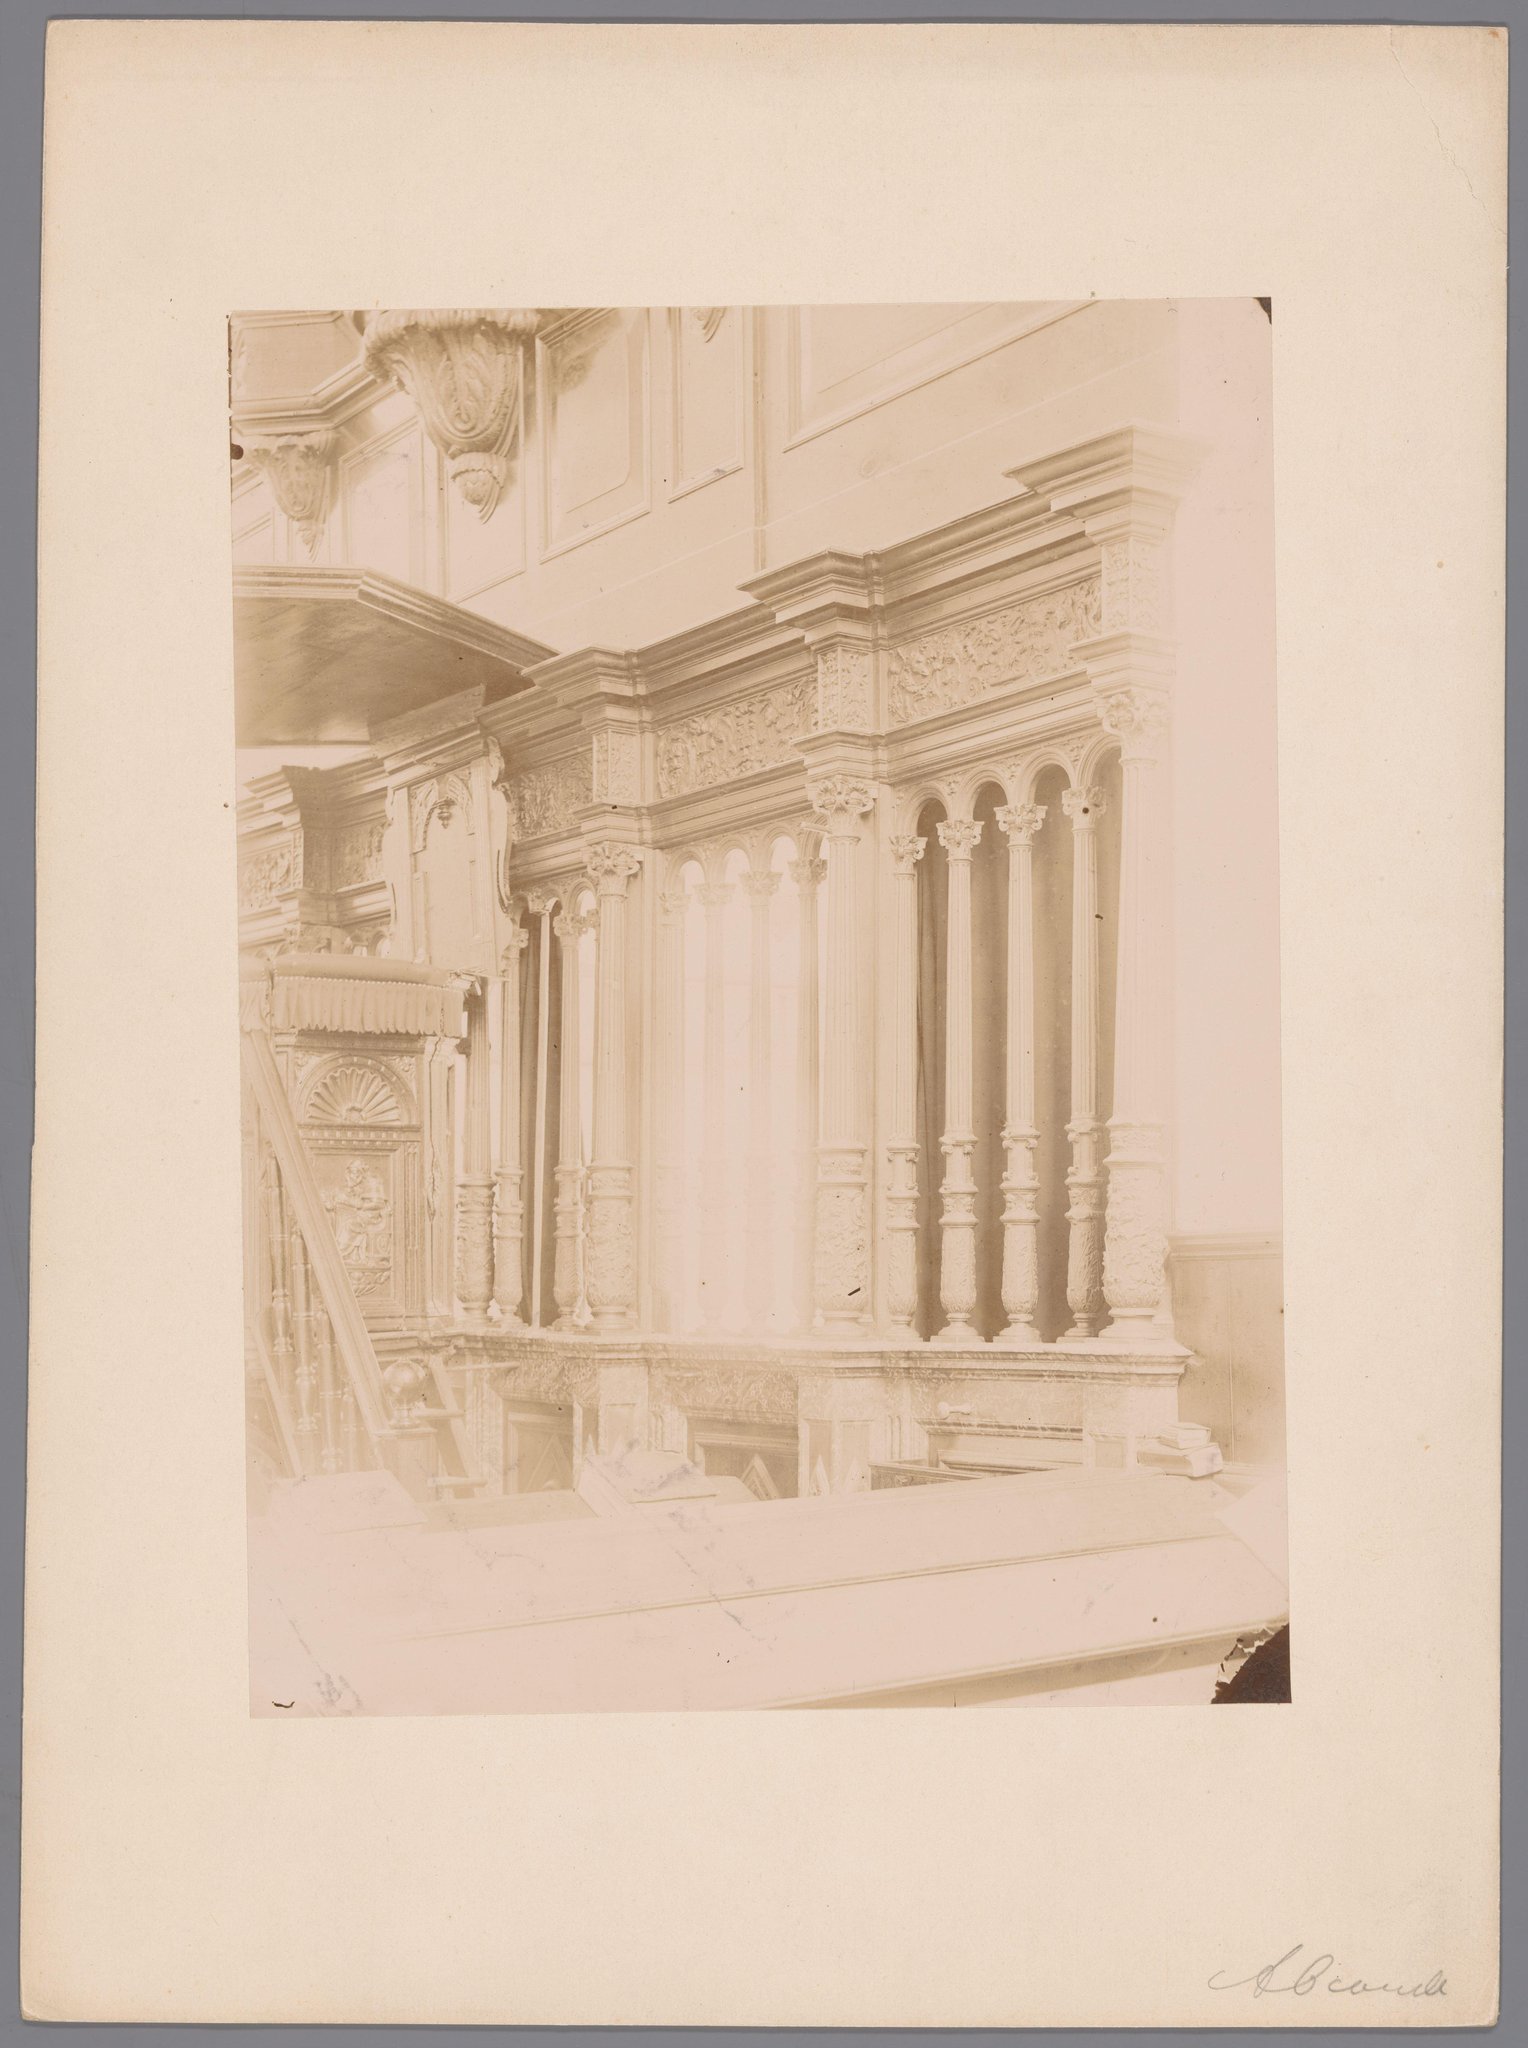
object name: photograph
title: Koorafsluiting in de Dorpskerk van Abcoude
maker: anoniem (monumentenzorg)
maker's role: fotograaf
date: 1893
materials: cardboard, photographic support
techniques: albumen print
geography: abcoude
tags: parts of church interior: choir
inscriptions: annotation: ‘Abcoude’, annotation: ‘Koorafsluiting in de kerk/ v/d Ned. Herv. gemeente te Abcoude (U.)/ aug 1893’